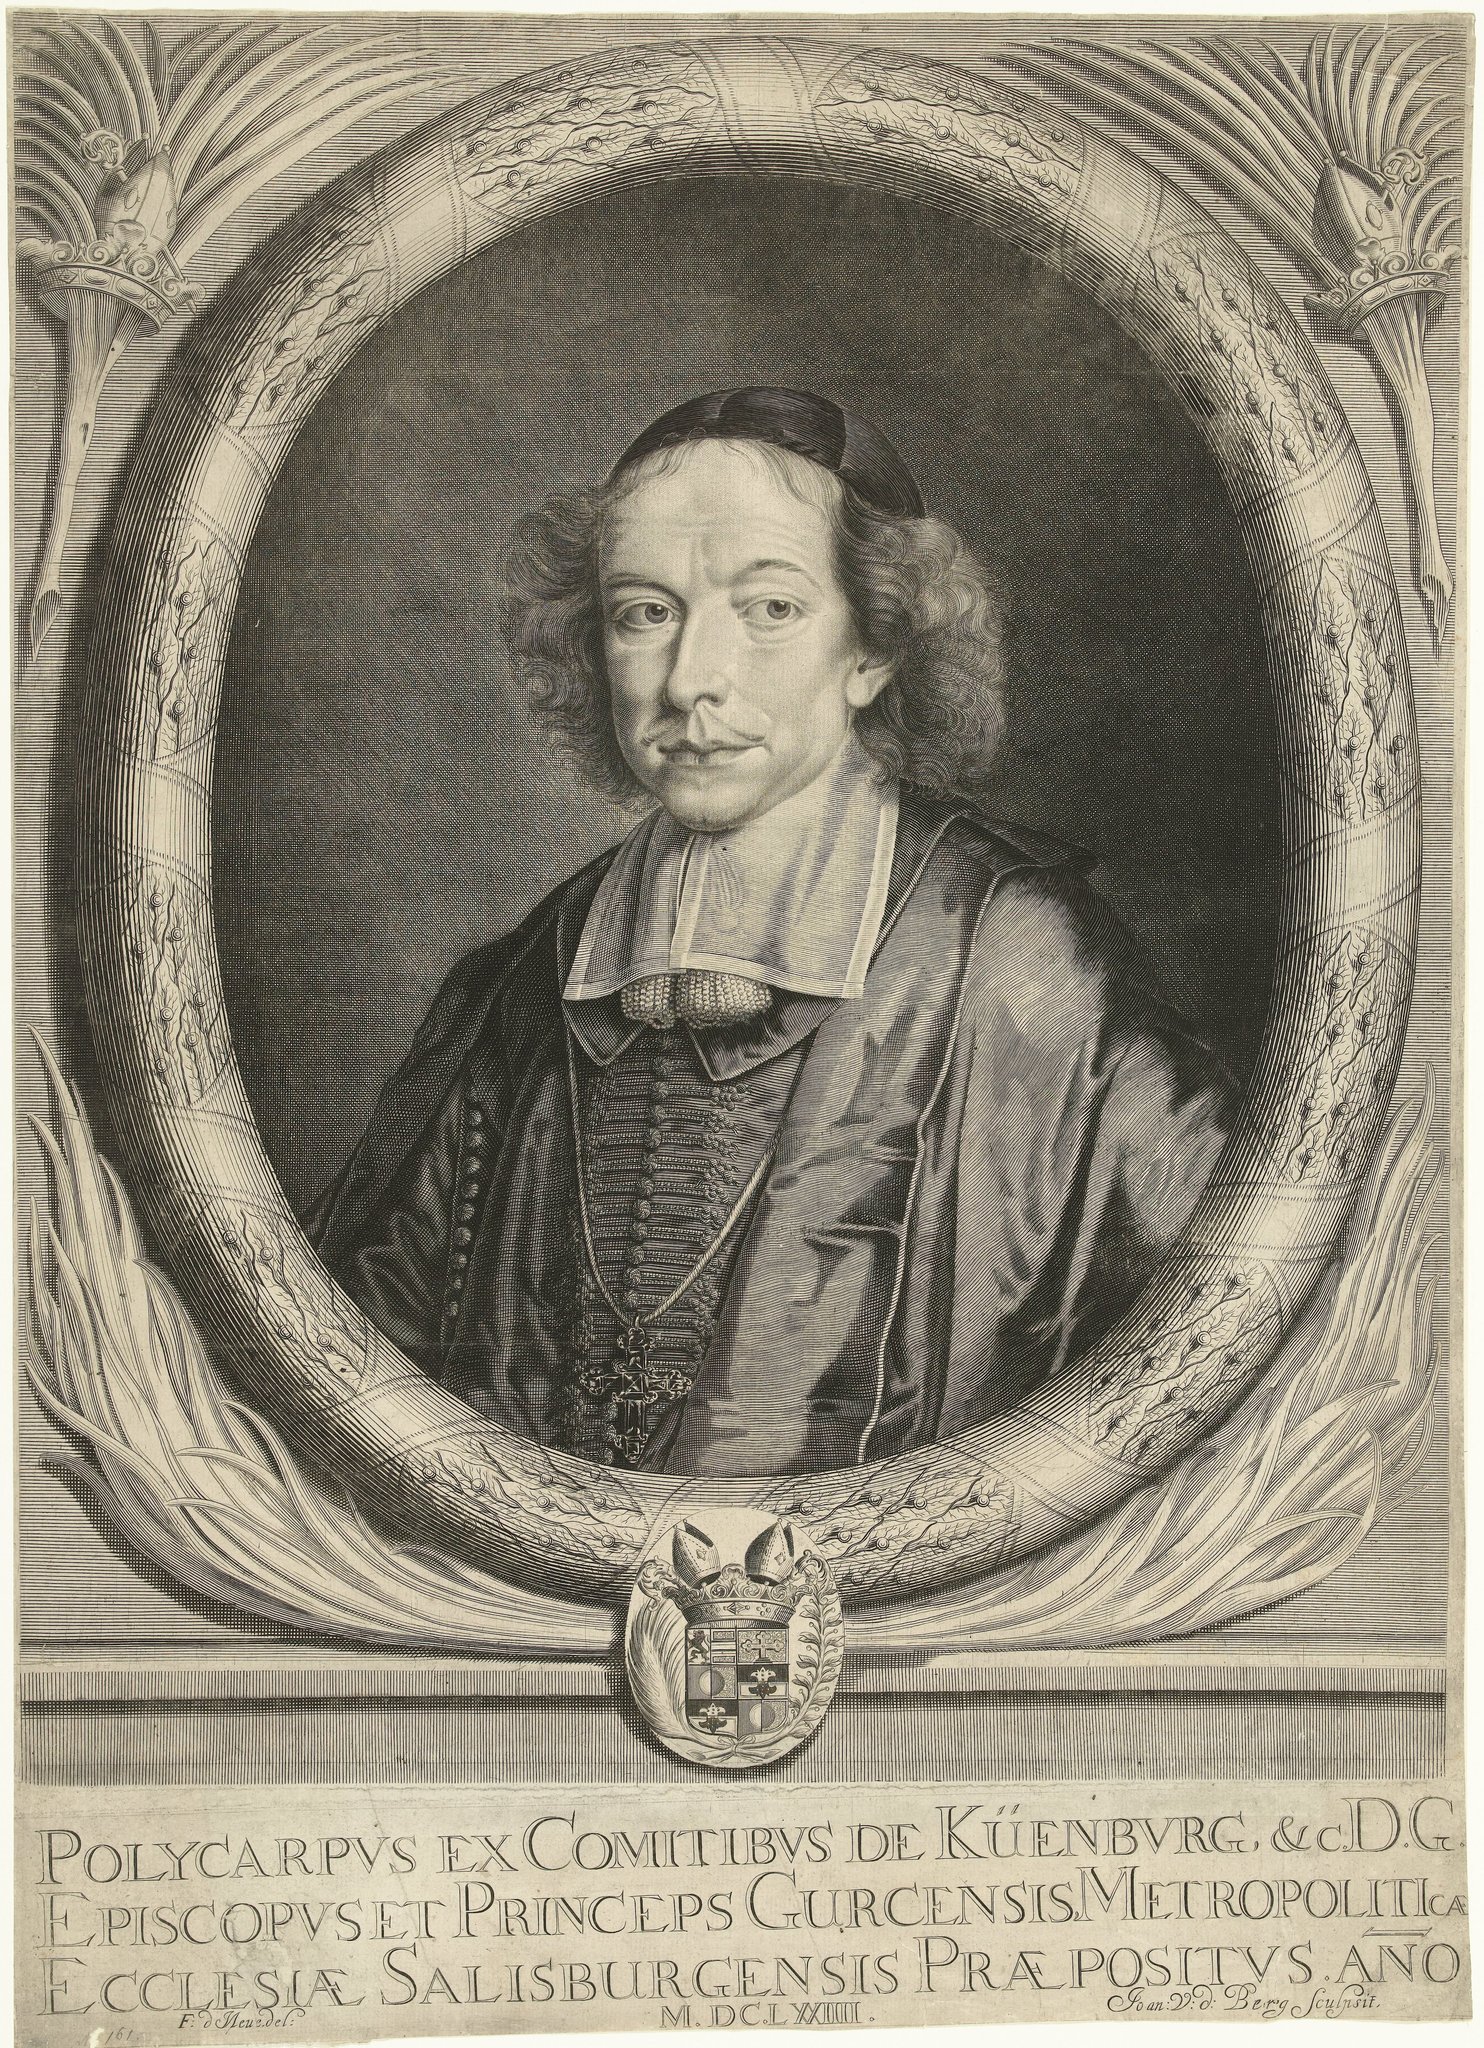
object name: print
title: Portret van graaf Polycarpus van Kuenburg, bisschop van Gork en proost van Salzburg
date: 1674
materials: paper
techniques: engraving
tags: archbishop, bishop, etc. (roman catholic)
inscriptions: date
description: Prent naar tekening van Franciscus de Neve.